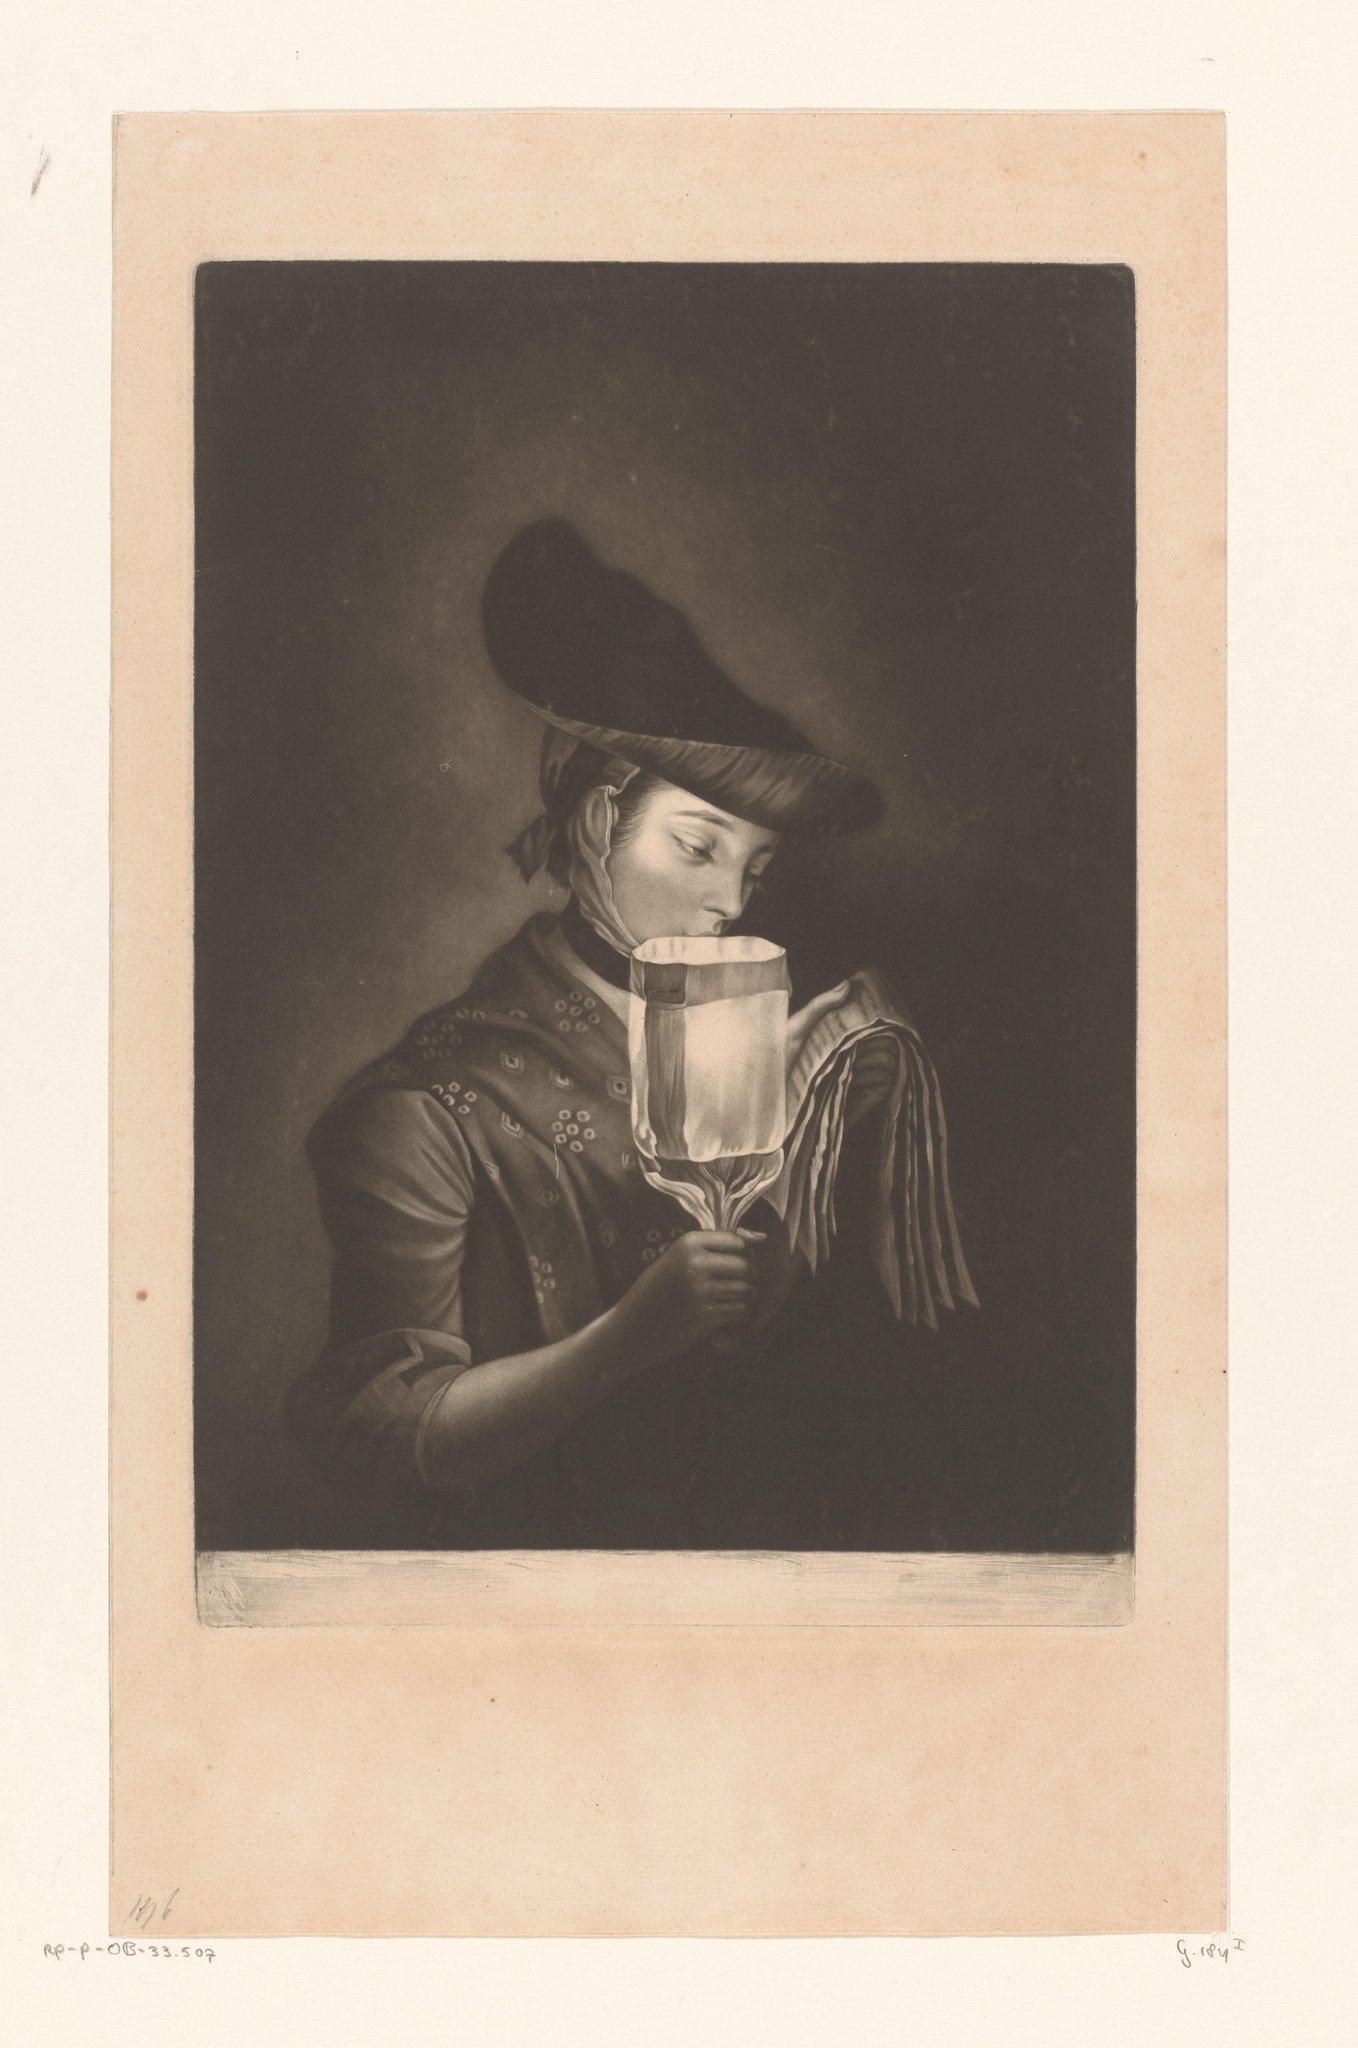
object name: print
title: Zangeres met papieren lantaarn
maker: james watson (prentmaker)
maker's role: print maker, publisher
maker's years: 1740-1790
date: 1765-1771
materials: paper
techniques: mezzotint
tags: lantern, ballad singer, ballad seller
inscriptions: collector's mark: Lugt 240